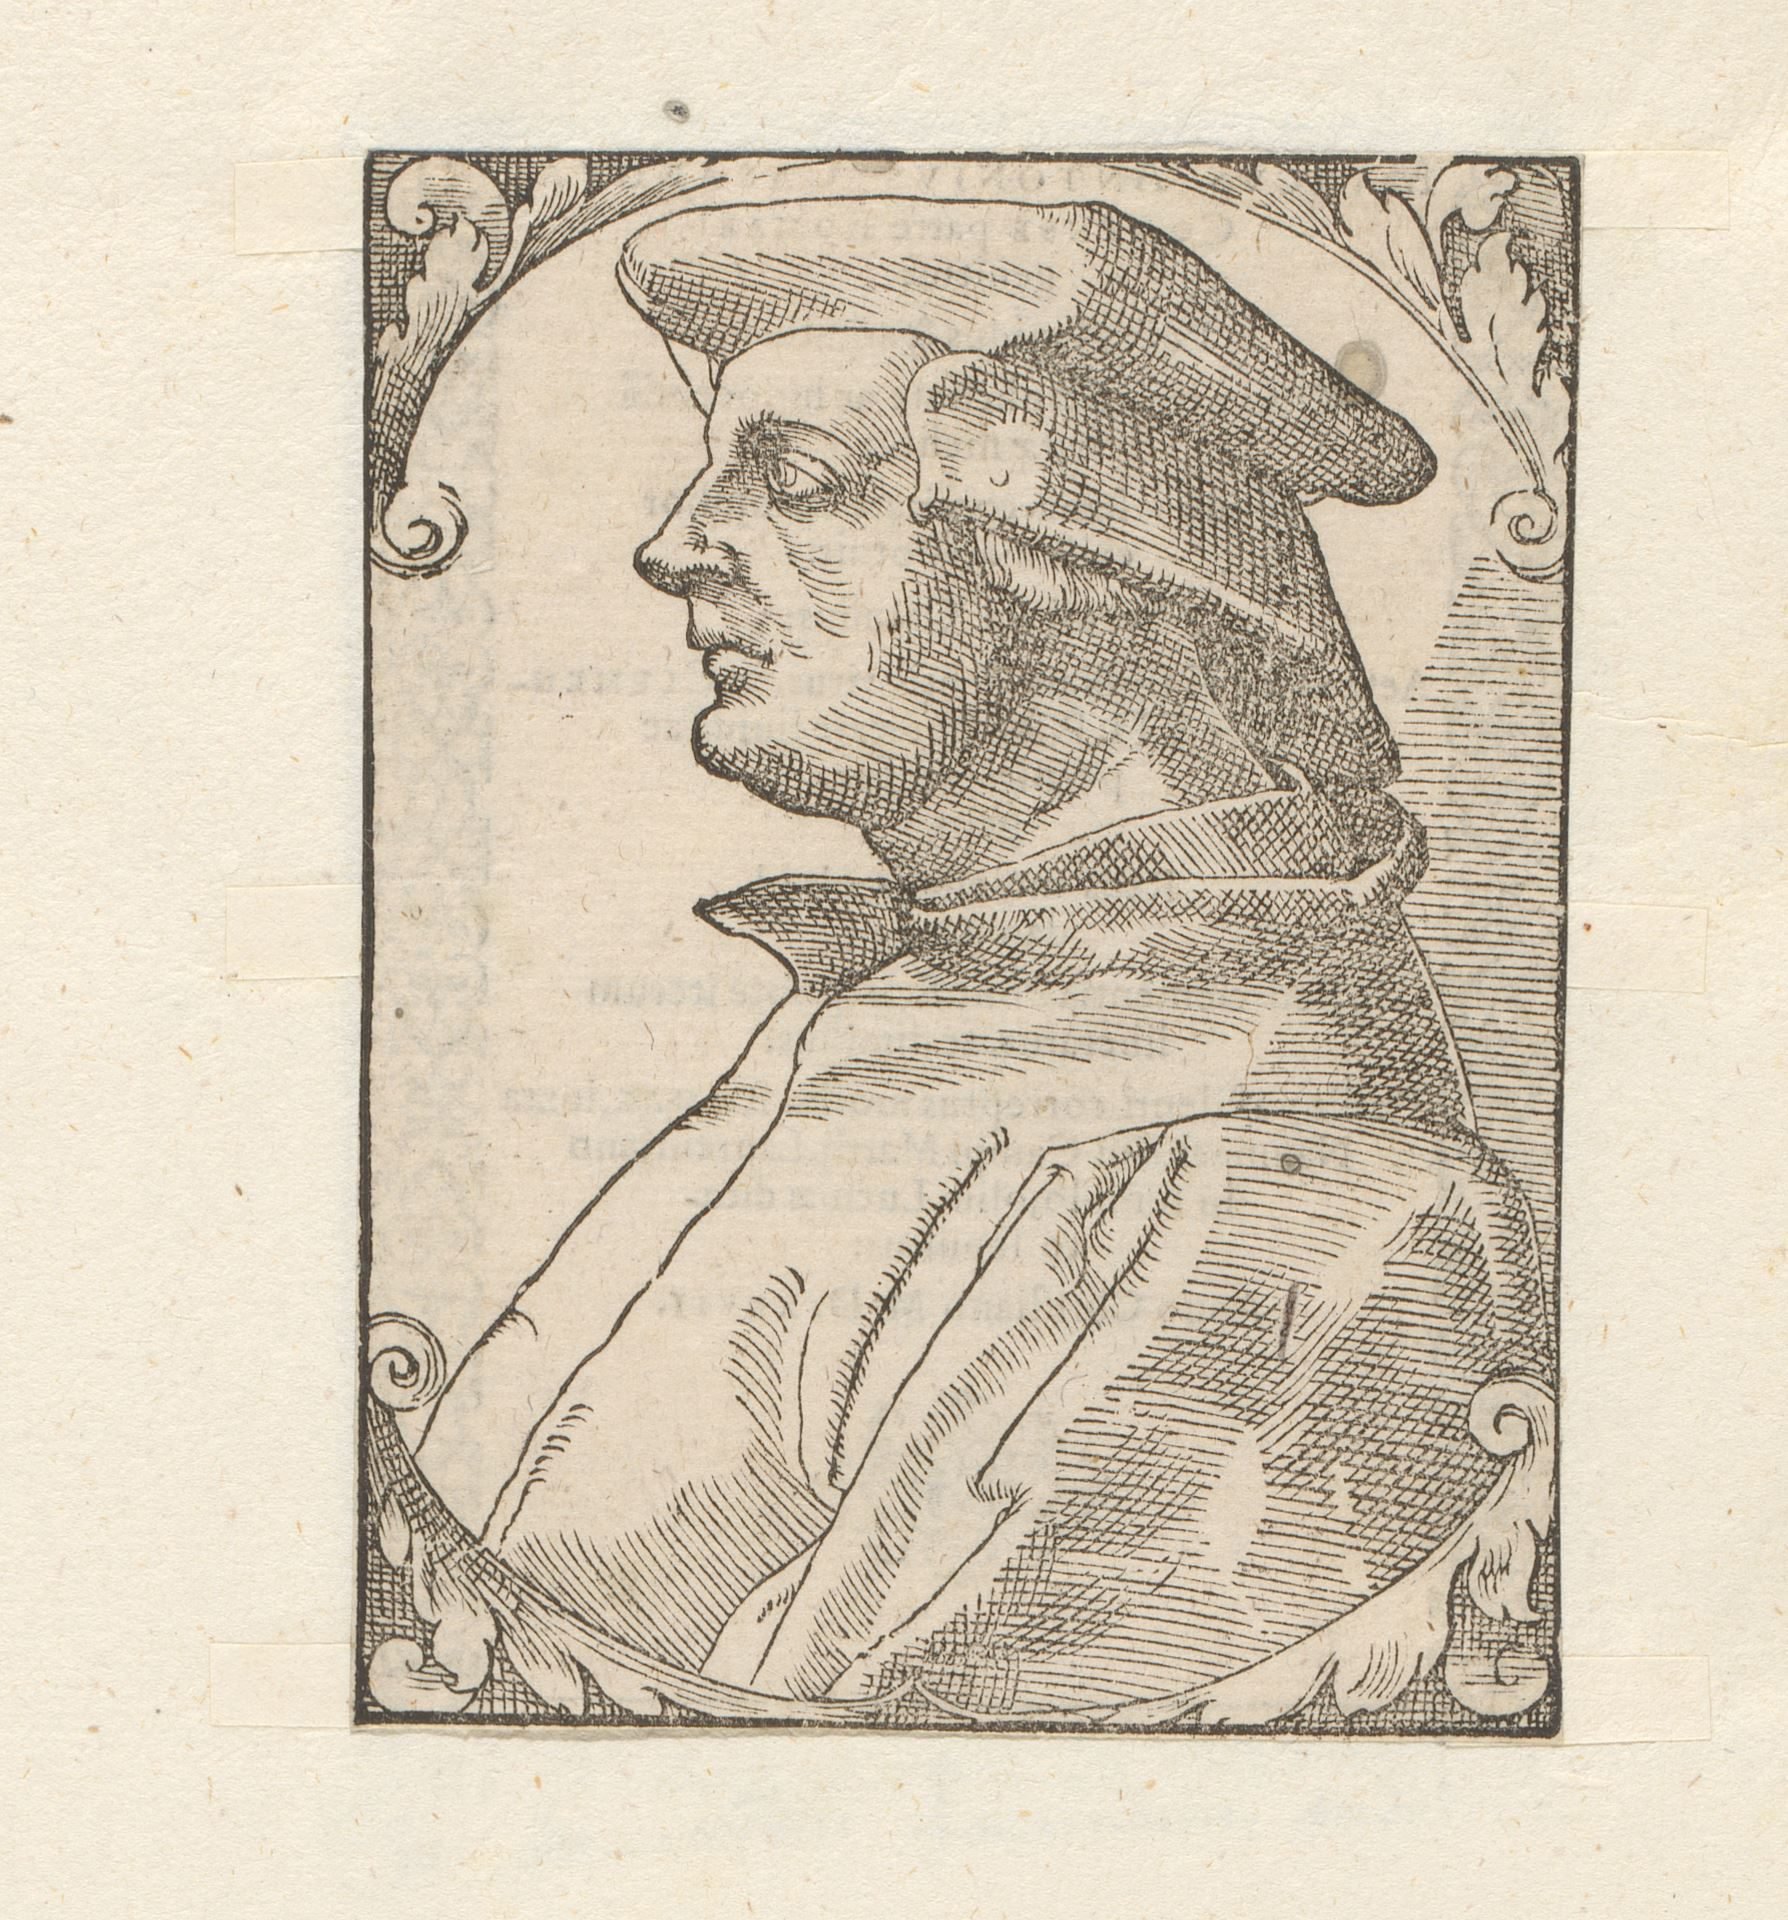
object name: book illustration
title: Portret van Marcantonio Casanova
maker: Anonymous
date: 1549-1577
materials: paper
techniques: letterpress printing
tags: historical persons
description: Prent gebruikt in: Giovio, Paolo. Elogia Virorum literis illustrium (...). Bazel: Peter Perna, 1577.